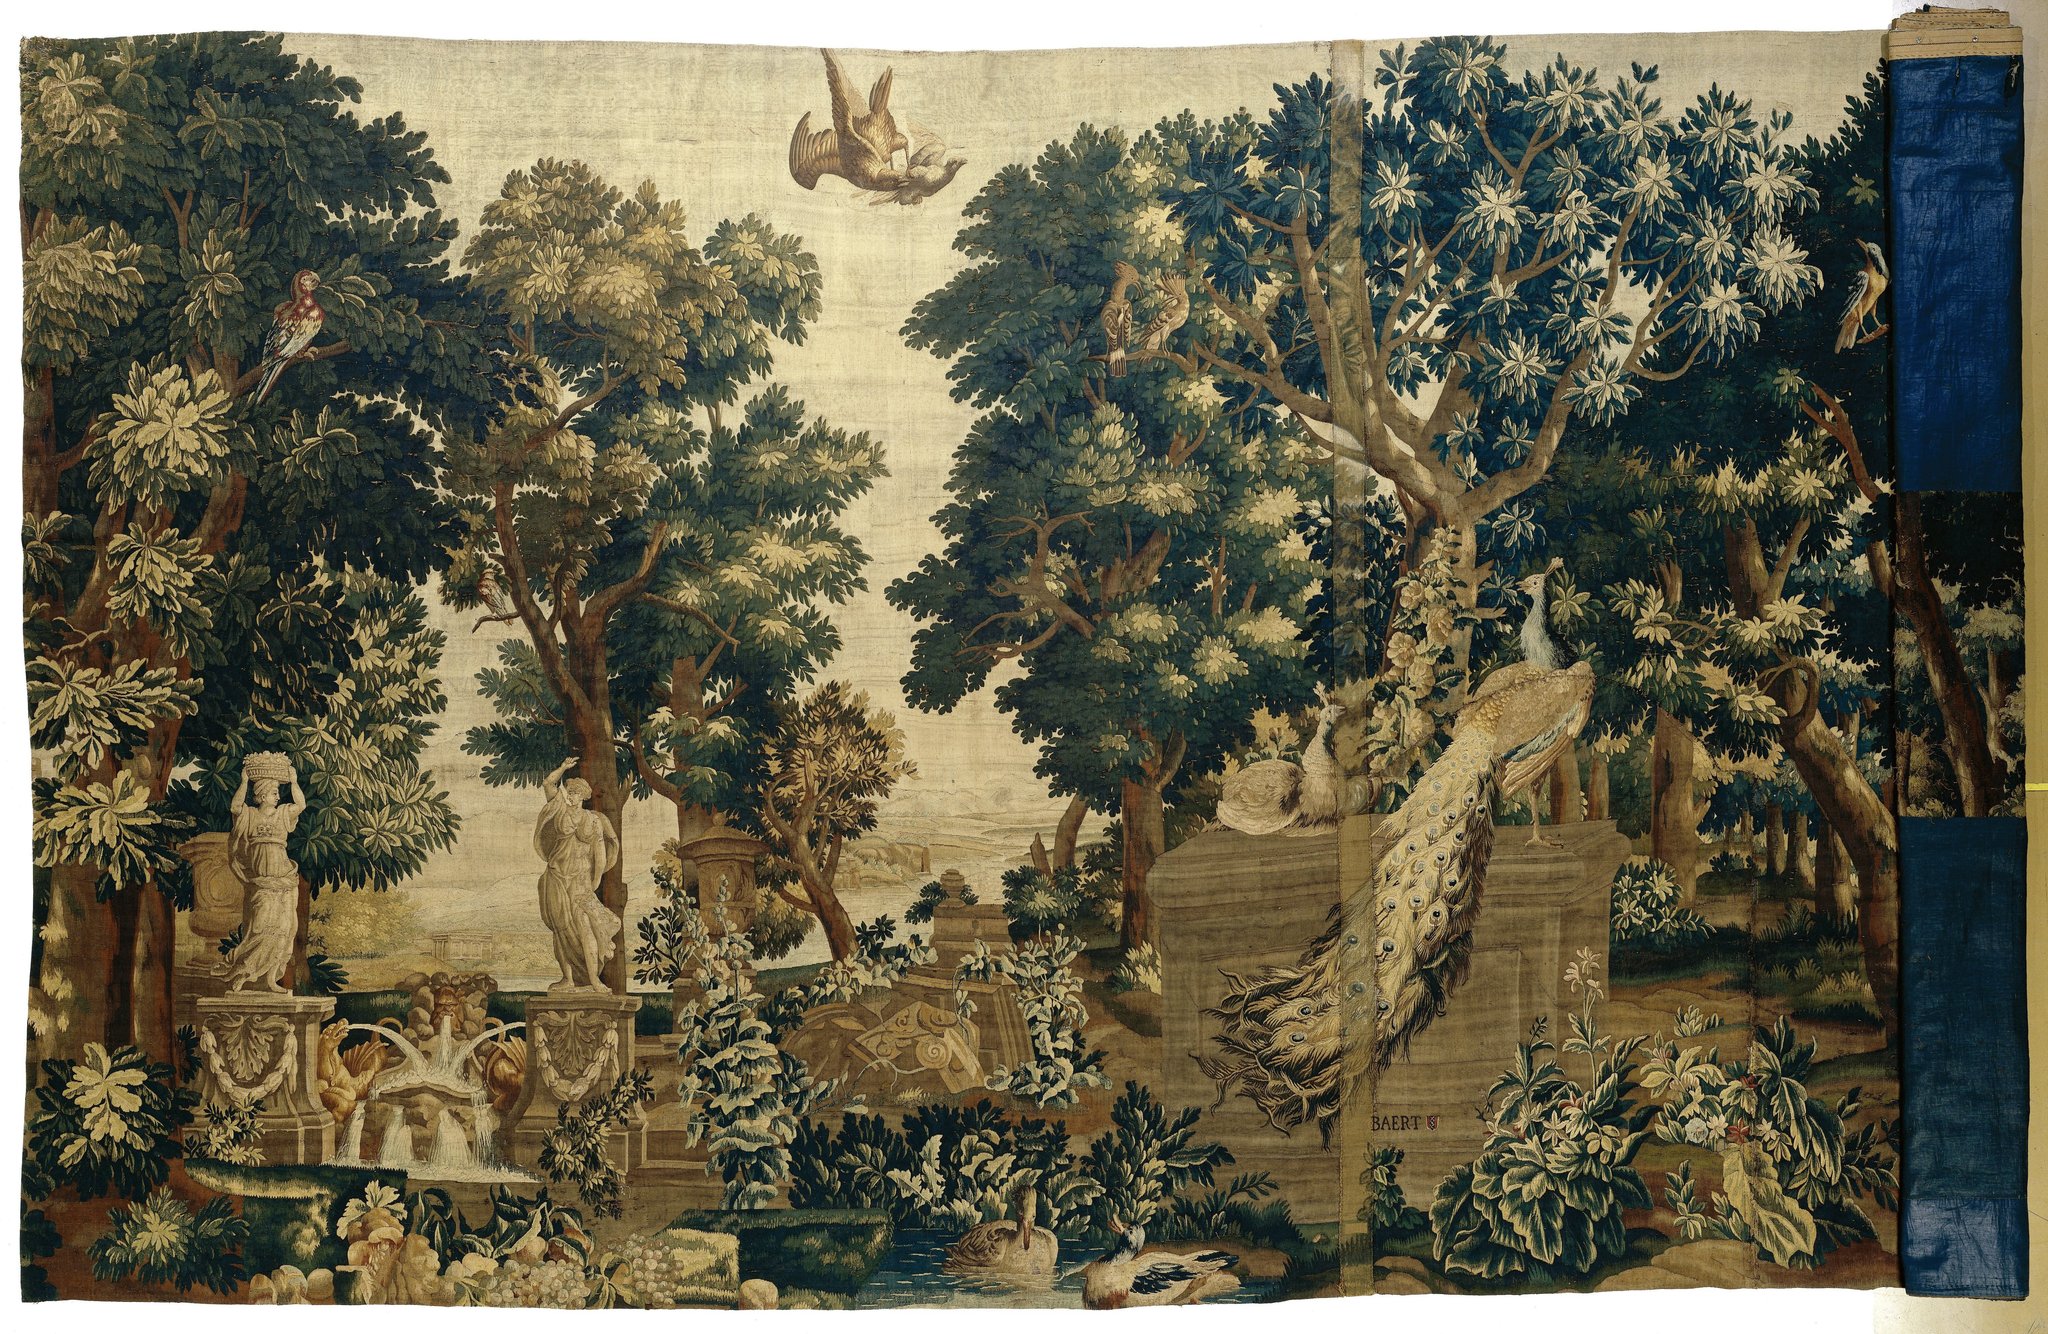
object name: tapestry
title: Bosrijk landschap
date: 1700-1730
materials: silk, wool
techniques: tapestry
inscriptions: mark, signature: ‘BAERT’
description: Wandtapijt of kamerbehangsel, landschapsverdure met park- en riviergezicht met pauw en kraanvogels. Signatuur "BAERT" en het wapen van Amsterdam